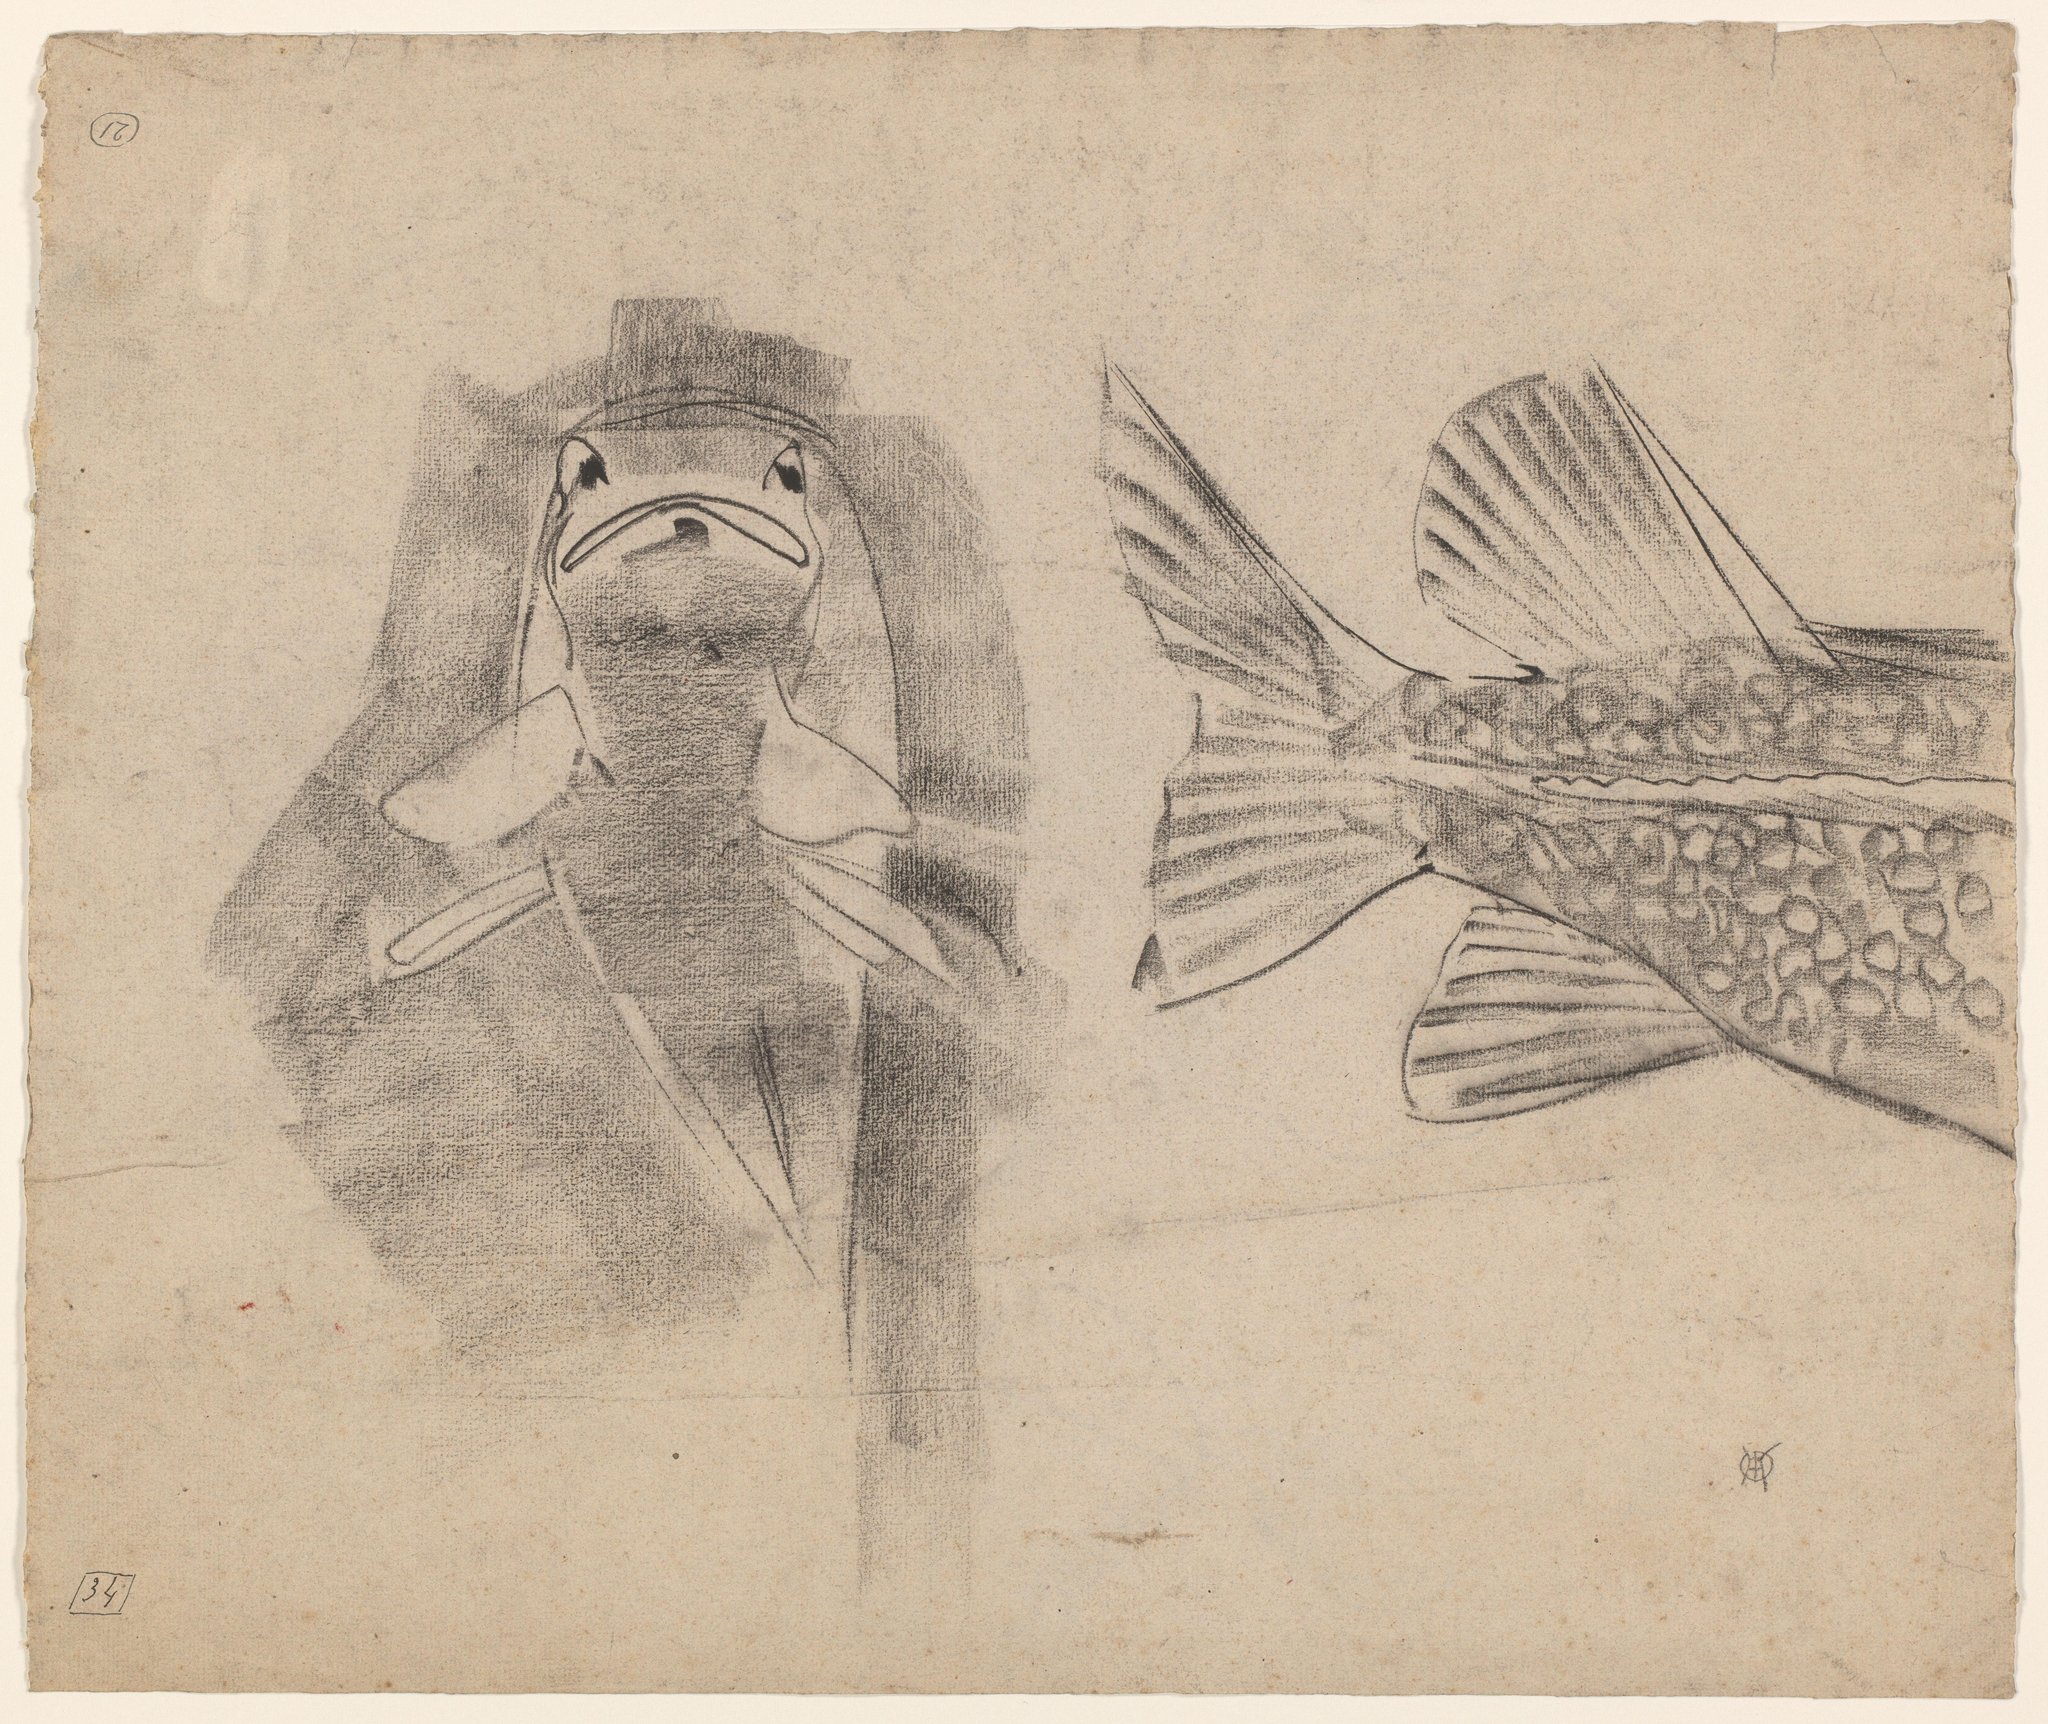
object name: drawing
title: Staart van een vis en een vis van onder gezien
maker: gerrit willem dijsselhof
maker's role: designer, draughtsman, print maker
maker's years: 1866-1924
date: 1876-1924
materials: chalk, paper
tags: bony fishes